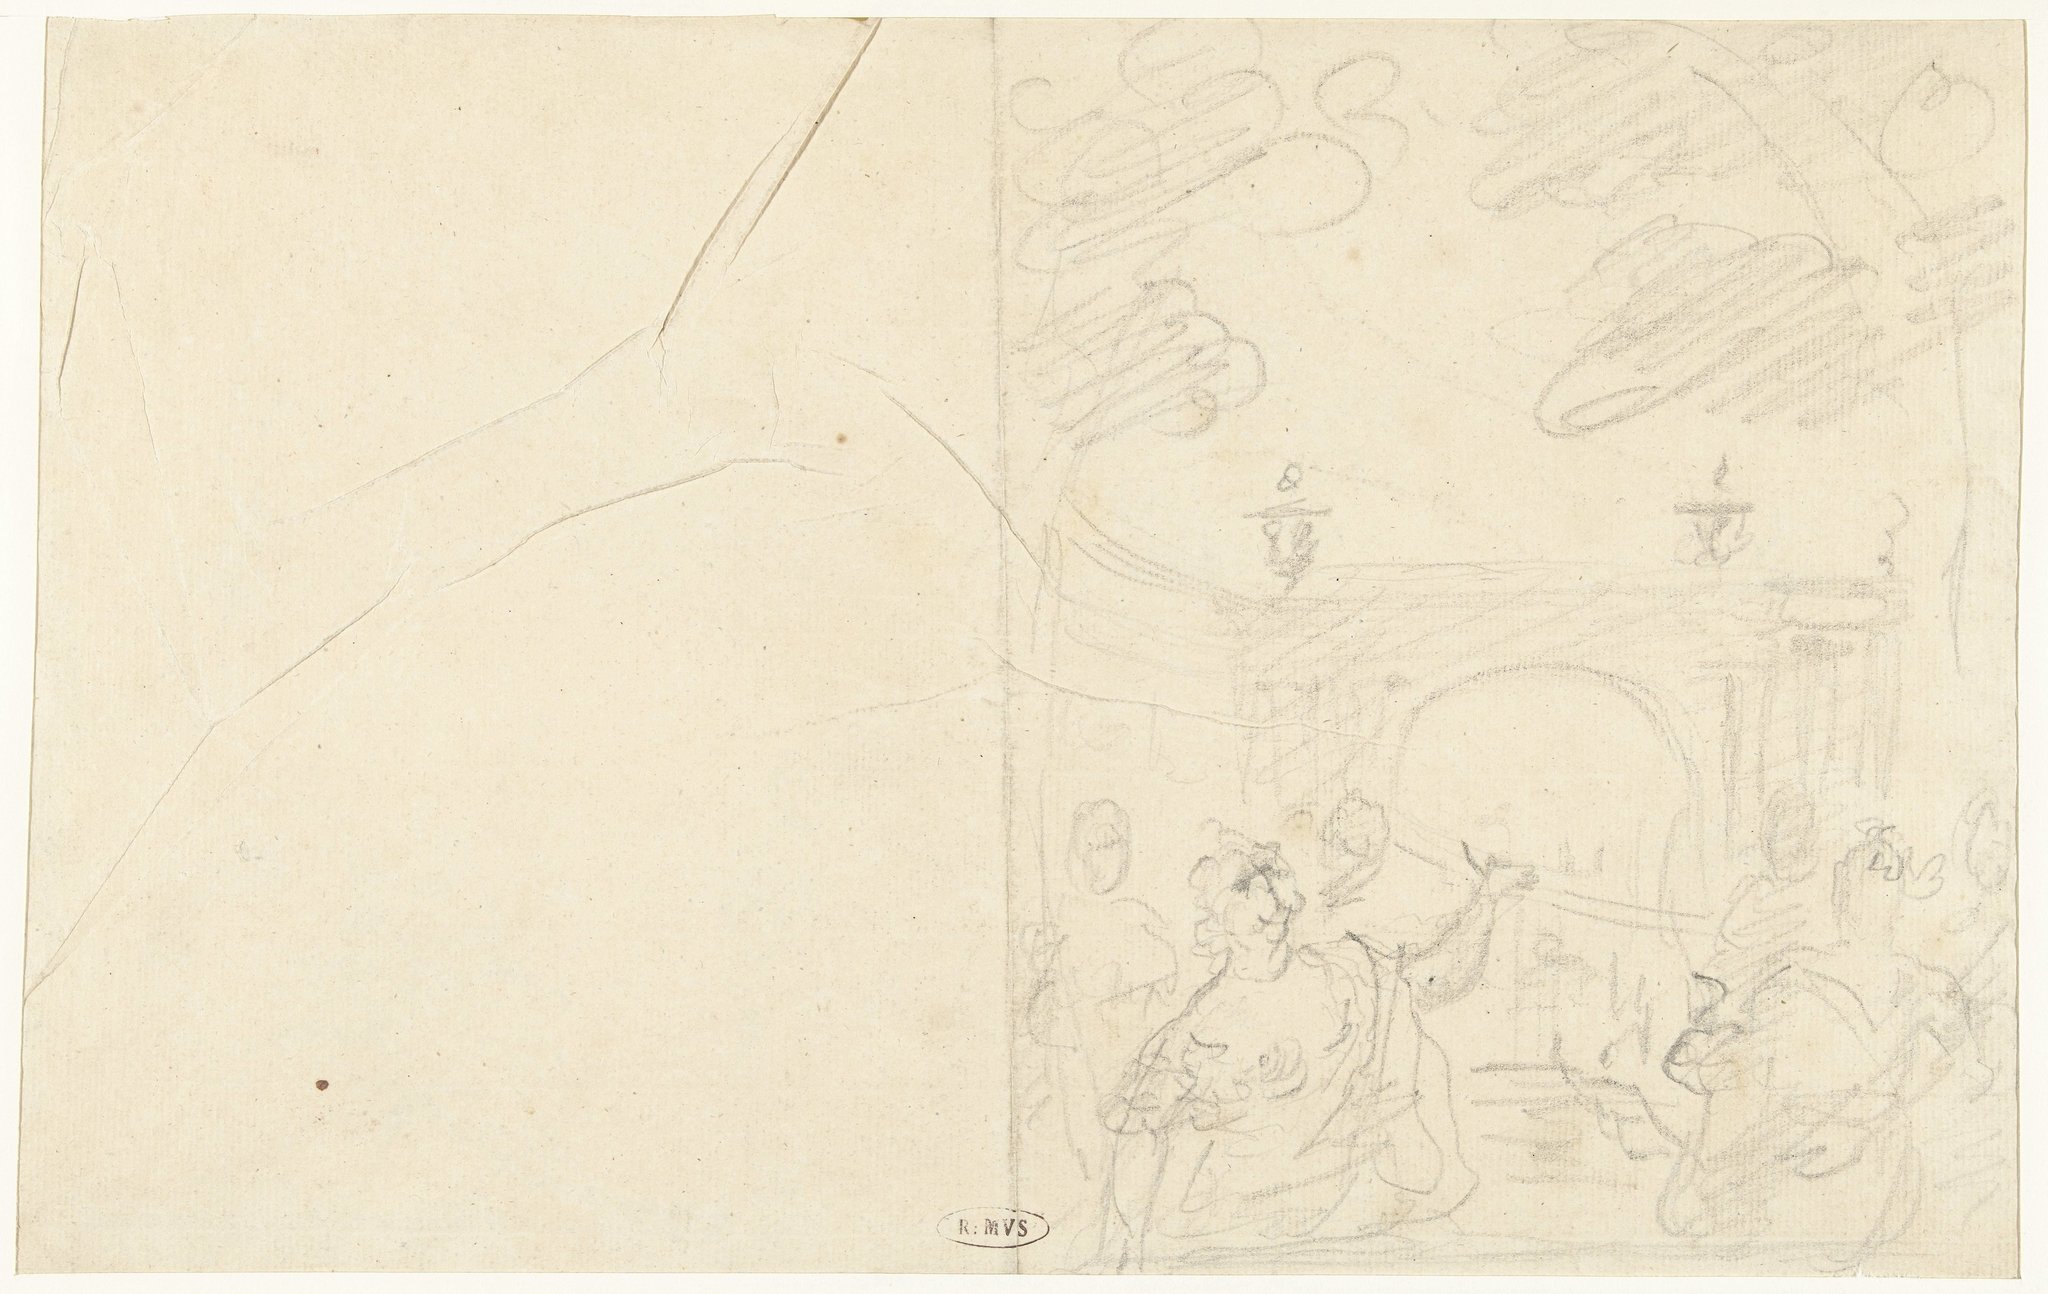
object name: drawing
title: Schets van figuren in een landschap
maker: dionys van nijmegen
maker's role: draughtsman, painter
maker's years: 1705-1798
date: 1715-1798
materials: paper, pencil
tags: garden